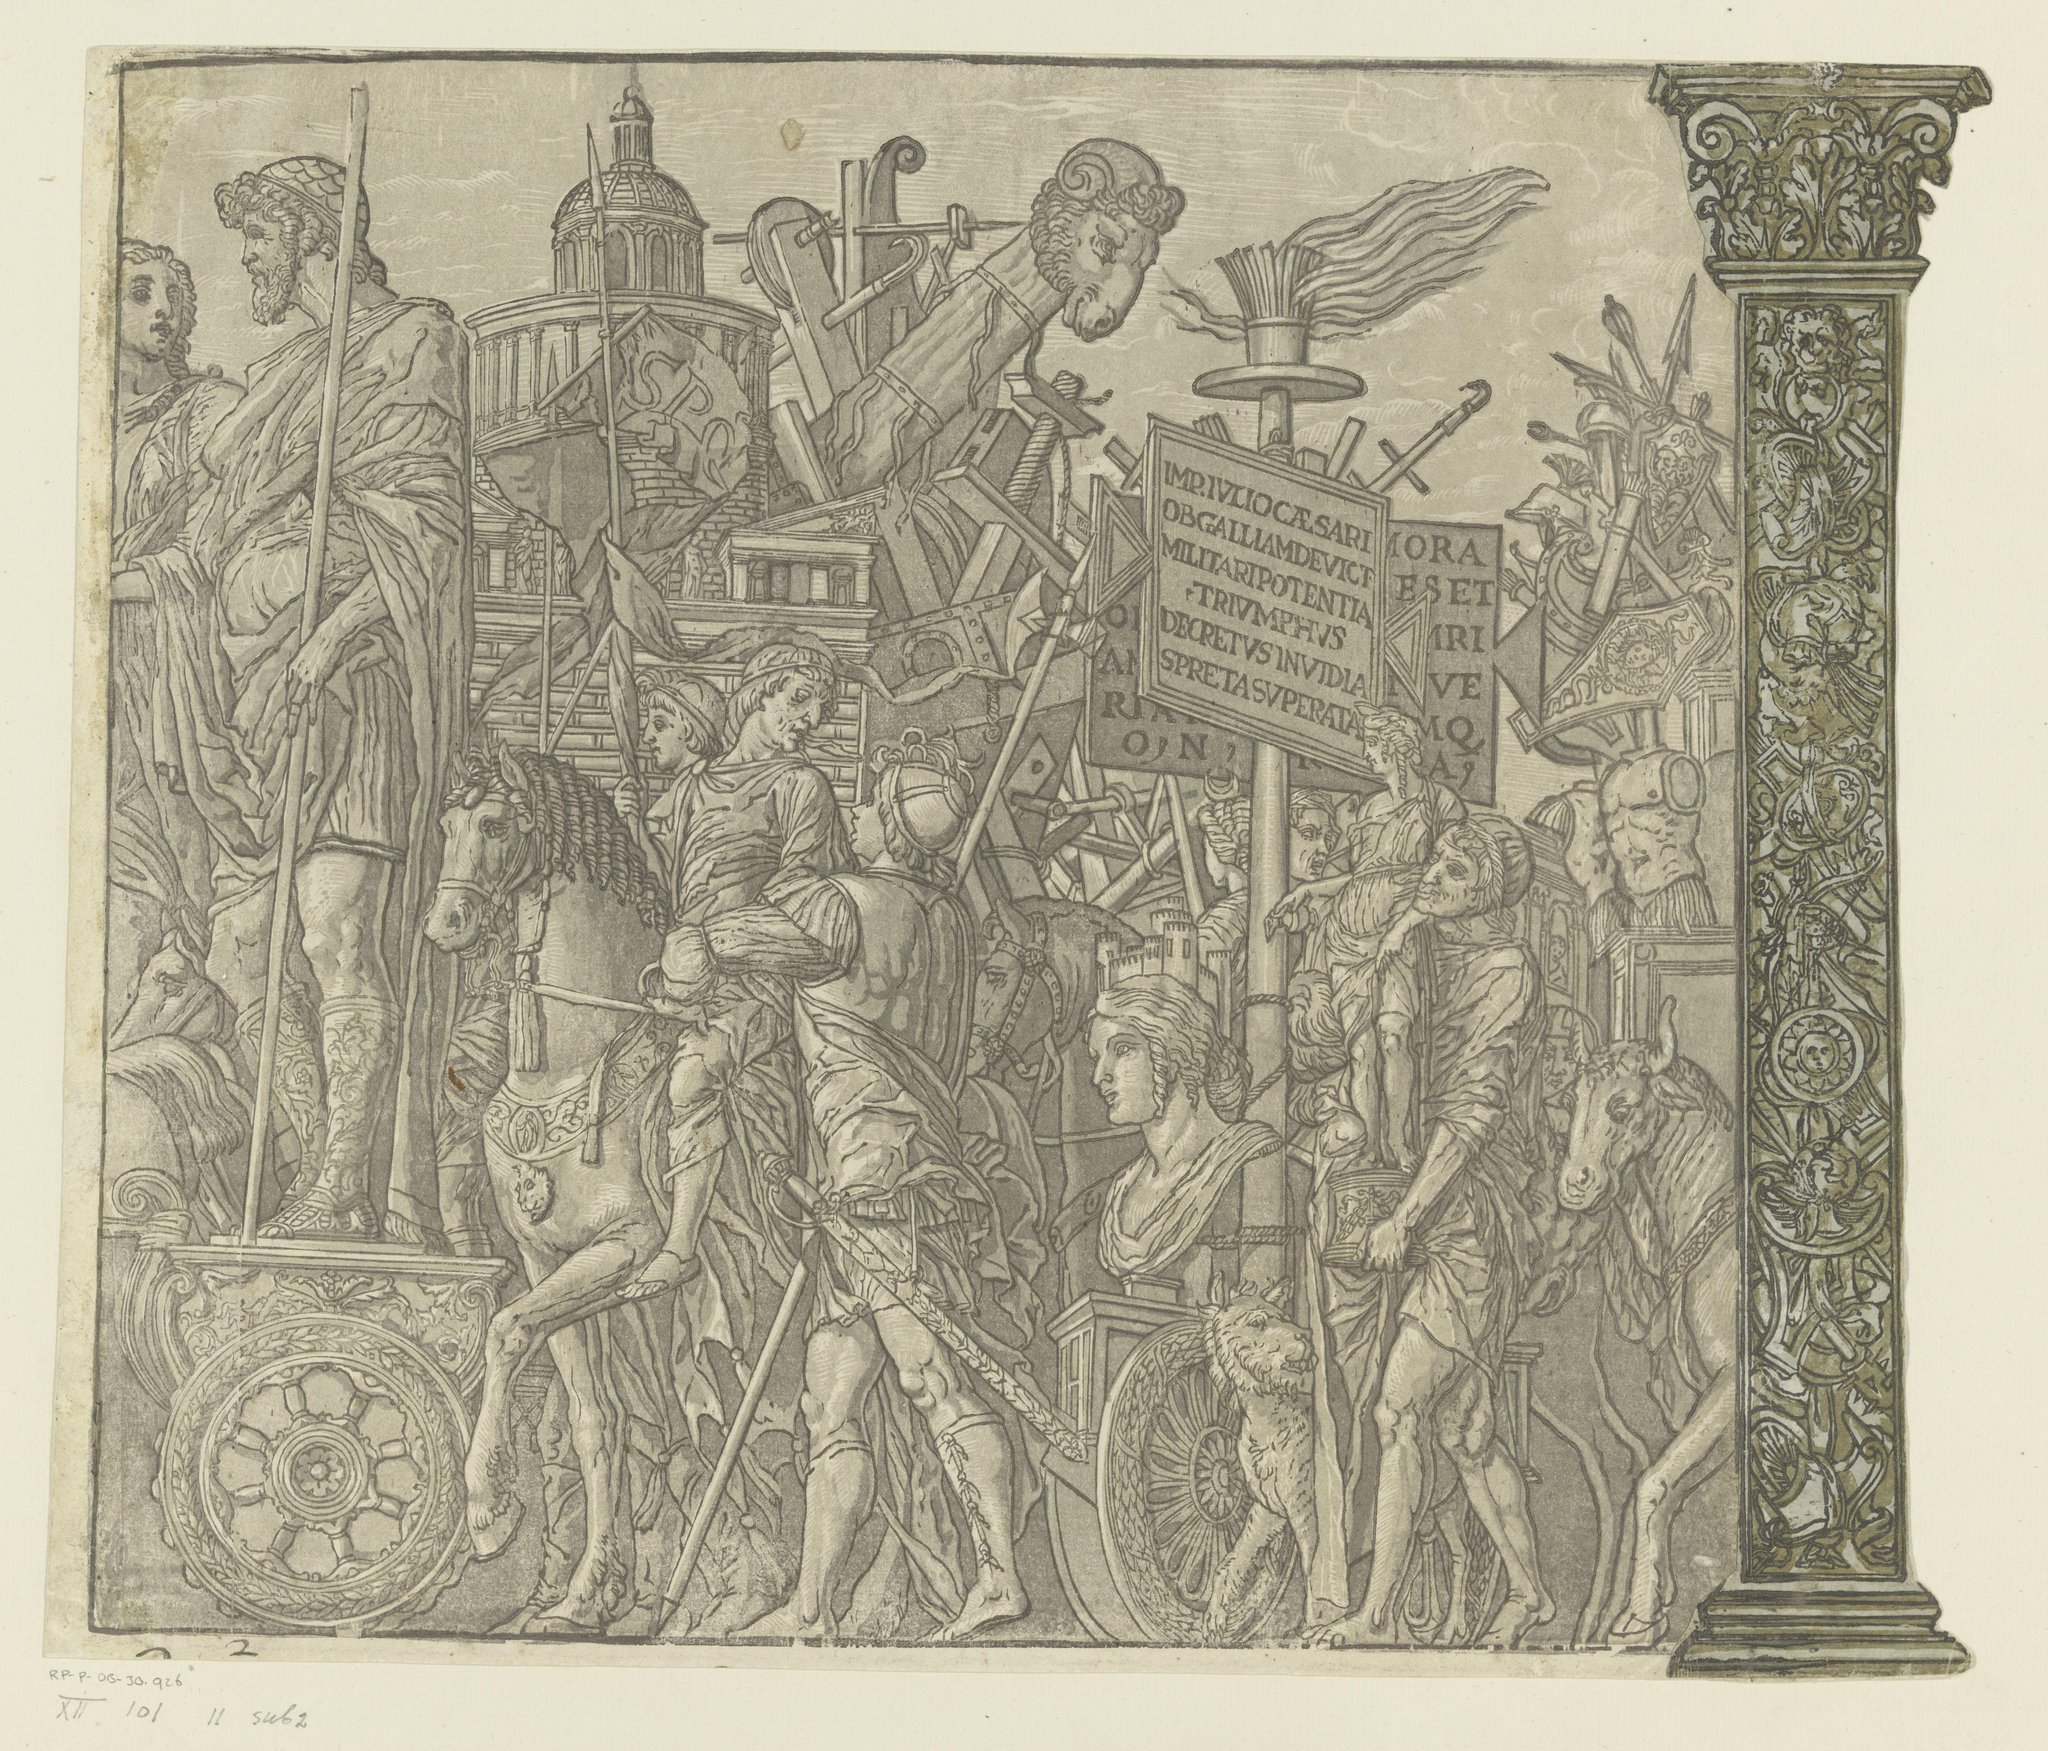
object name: print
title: Triomftocht van Julius Caesar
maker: andrea andreani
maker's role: print maker, printer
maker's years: 1558-1629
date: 1599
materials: paper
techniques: woodcut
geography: mantua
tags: torch, triumph of caesar, piece of sculpture, reproduction of a piece of sculpture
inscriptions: collector's mark: Lugt 240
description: Deze prent maakt deel uit van een fries dat bestaat uit een titelprent en negen prenten die samen een triomftocht van Julius Caesar vormen. Bij de serie hoort tevens een prent met daarop zes Korinthische pilasters, bedoeld om te worden uitgeknipt en gebruikt als verbindingsstukken tussen de verschillende bladen. Op dit exemplaar is een pilaster aan de rechterkant gemonteerd. Op de achterzijde van de pilaster een afdruk van een andere clair-obscur houtsnede.